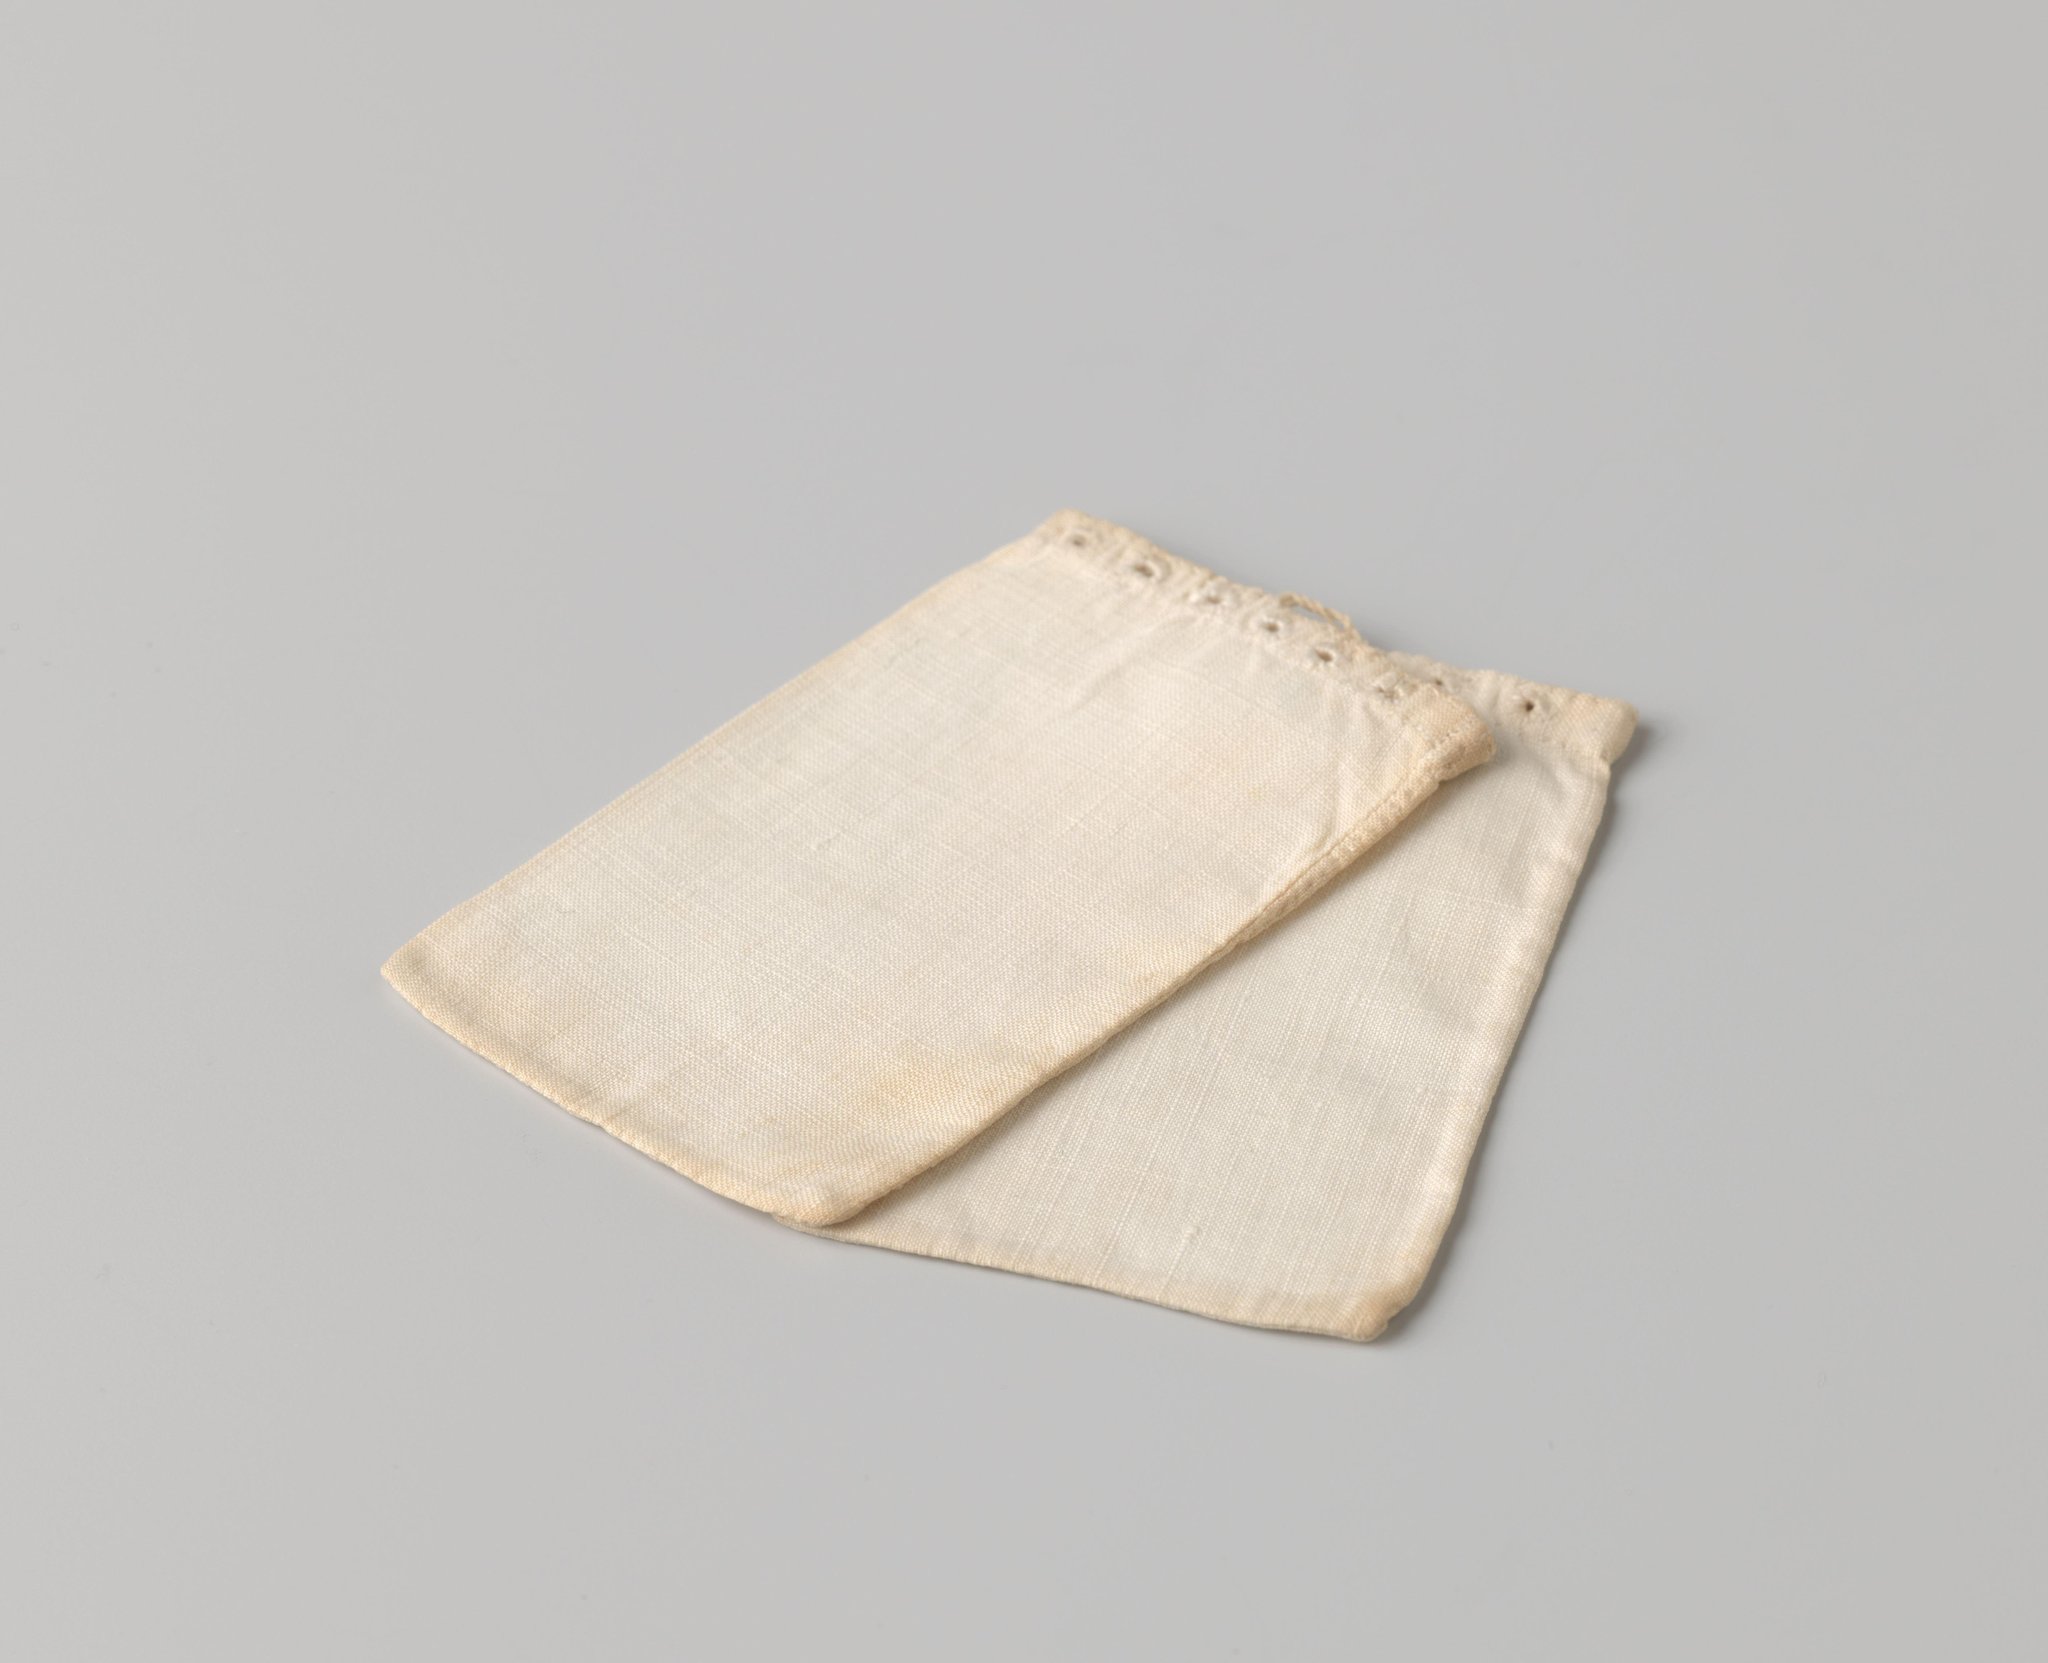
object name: sloop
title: Sloop met koordsluiting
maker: Anonymous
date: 1750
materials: linen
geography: netherlands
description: Sloop voor kussen, aan korte zijde voorzien van zes gaten voor koordsluiting.